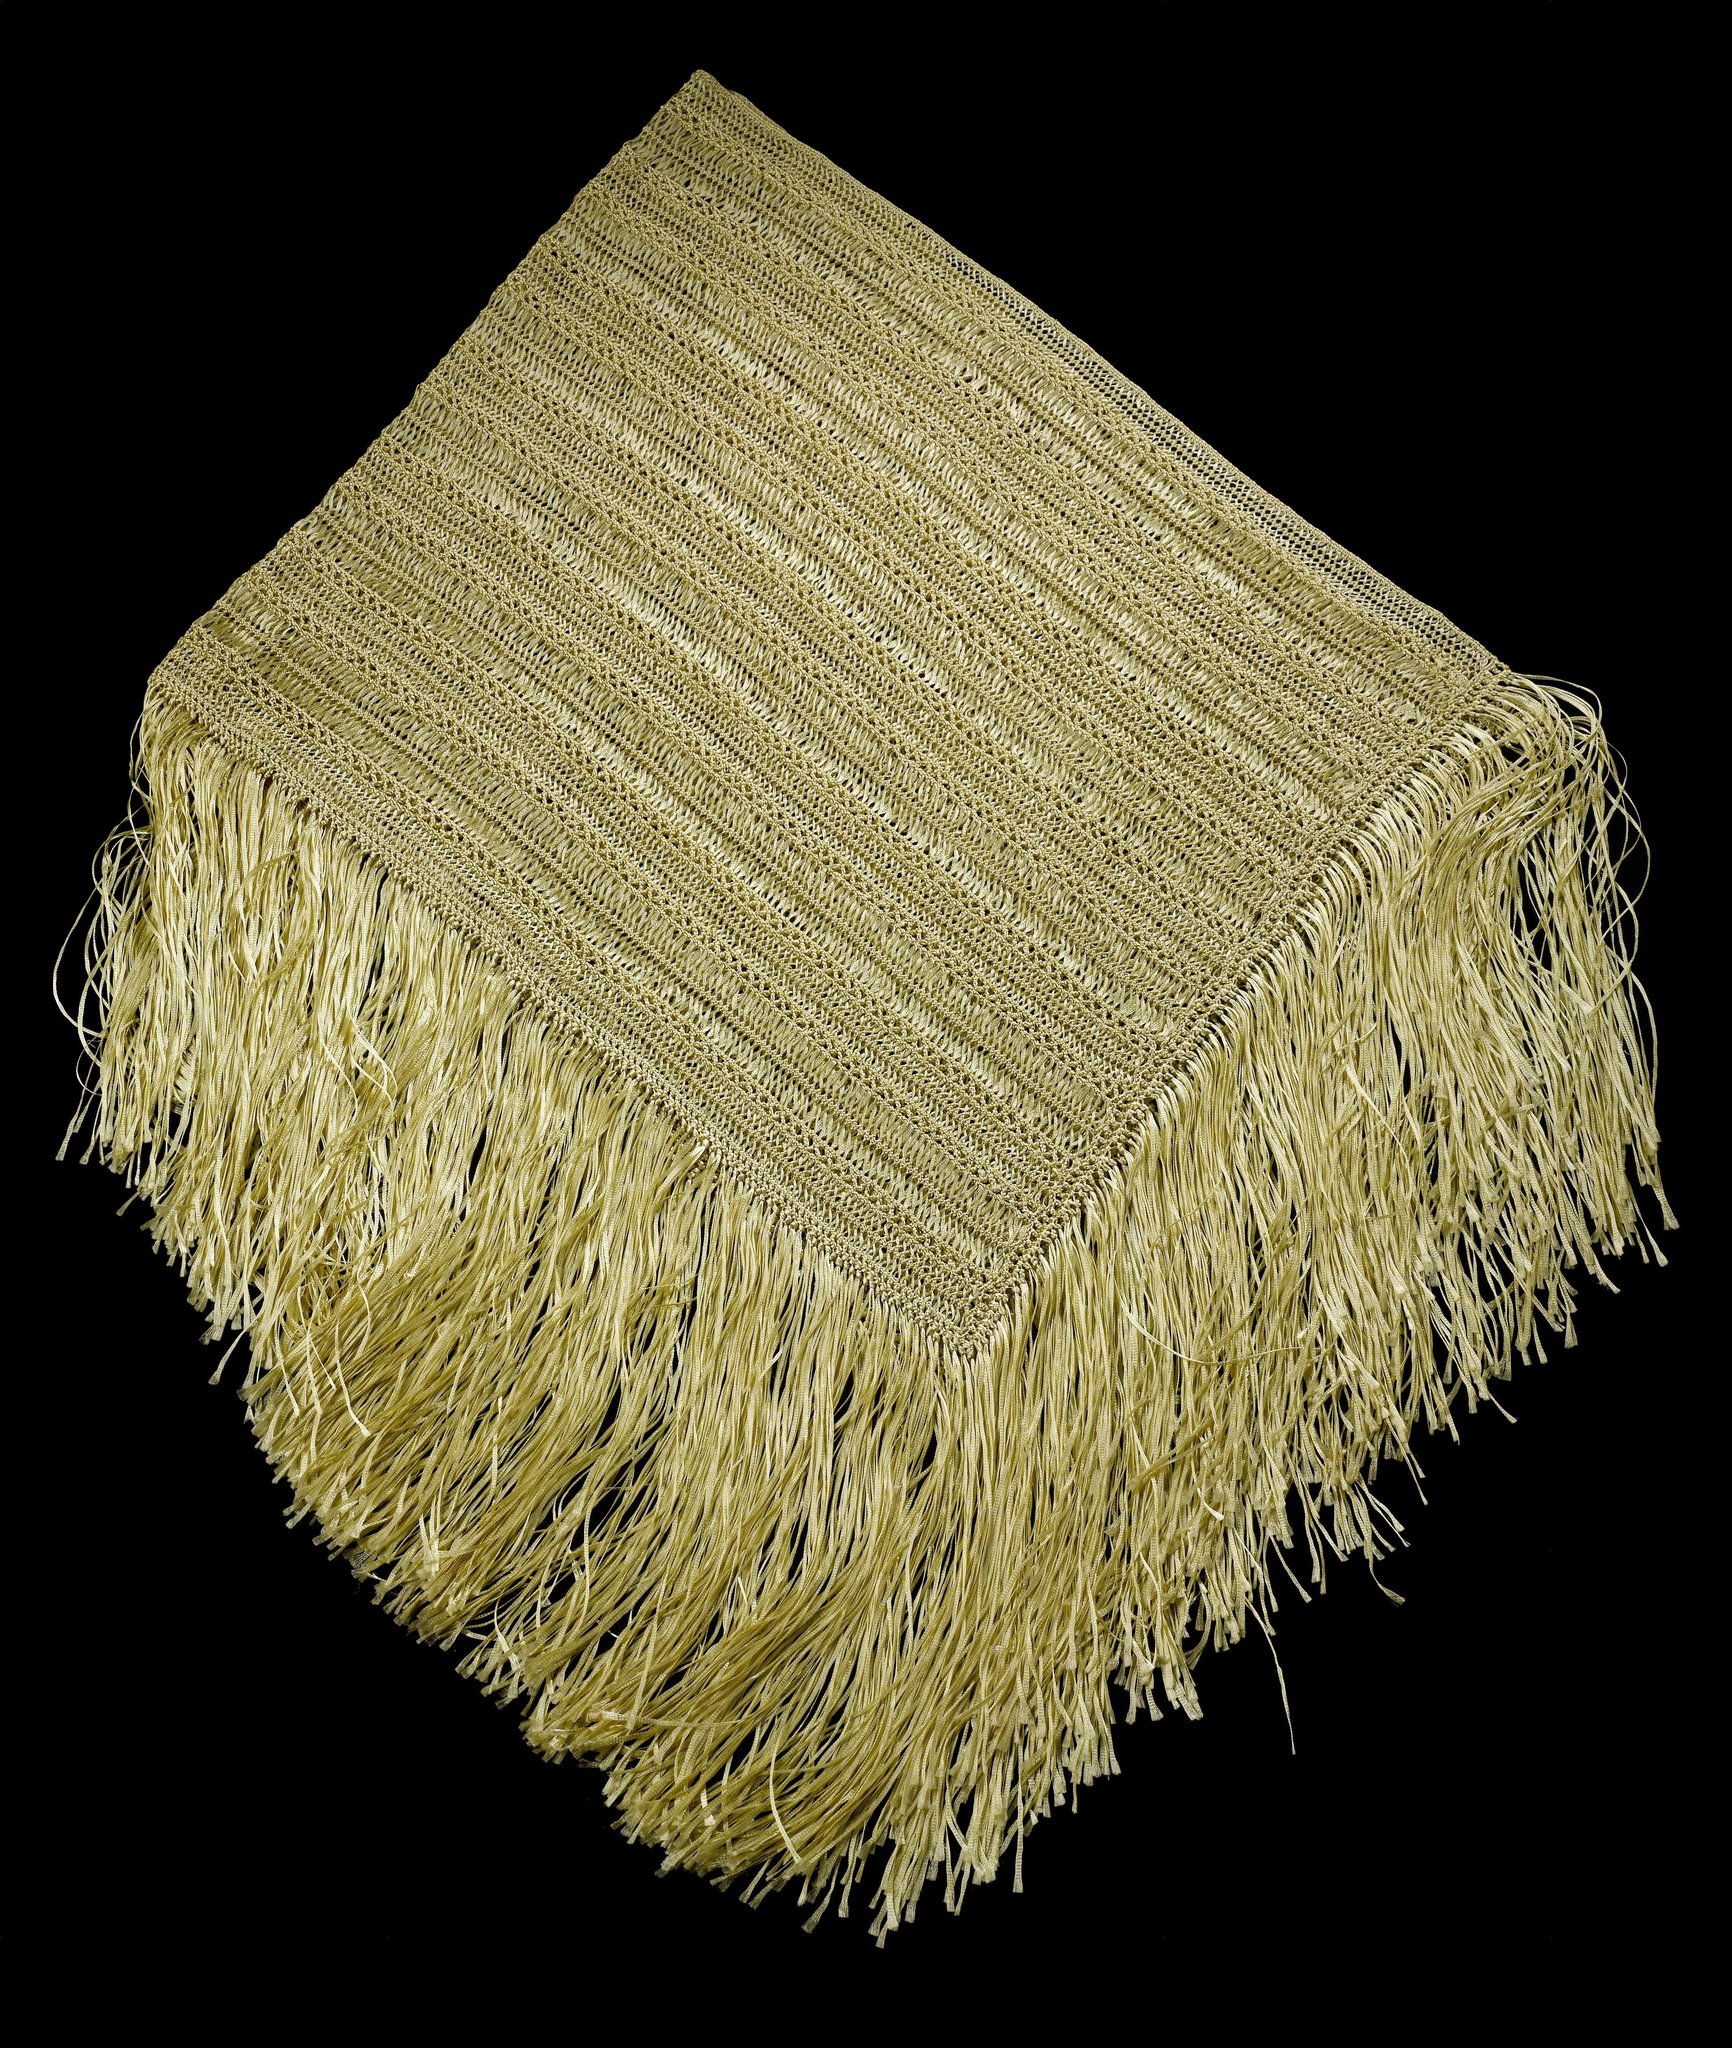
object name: clothing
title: Vierkante sjaal van geel zijden tres, langs drie zijden voorzien van een lange franje van hetzelfde tres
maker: cornelia elisabeth siewertsz van reesema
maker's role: artisan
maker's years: 1881-1954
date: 1907-1910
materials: silk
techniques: crochet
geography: arnhem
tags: cornelia elisabeth siewertsz van reesema, arnhem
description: De sjaal werd gemaakt door mej. C.E. Siewertsz van Reesema. In 1907 opende zij - samen met mej. E. Nierstrasz - een winkel voor toegepaste kunst in Arnhem, 't Spinnewiel. Zij verkochten daar hun eigen borduurwerken, maar hadden tevens de vertegenwoordiging voor Arnhem van 'N.V. de Woning' (Leidsestraat, Amsterdam) met werk van o.a. W. Penaat en J. Eisenlöffel. Volgens overlevering zouden er twee van deze sjaals zijn: één cadeau gedaan aan Cornelia Elisabeth Siewertsz van Reesema (dochter van Frederik, broer van de maakster), petekind en één voor koningin Emma of Wilhelmina. Volgens de schenkster - dochter van het nichtje en petekind - zou zich aan het hof een foto bevinden waarop de koningin de sjaal draagt. Petekind Cornelia Elisabeth Siewertsz van Reesema trouwde met haar neef William (zoon van tante's broer Alfred) Siewertsz van Reesema en draagt daarom twee keer deze naam.